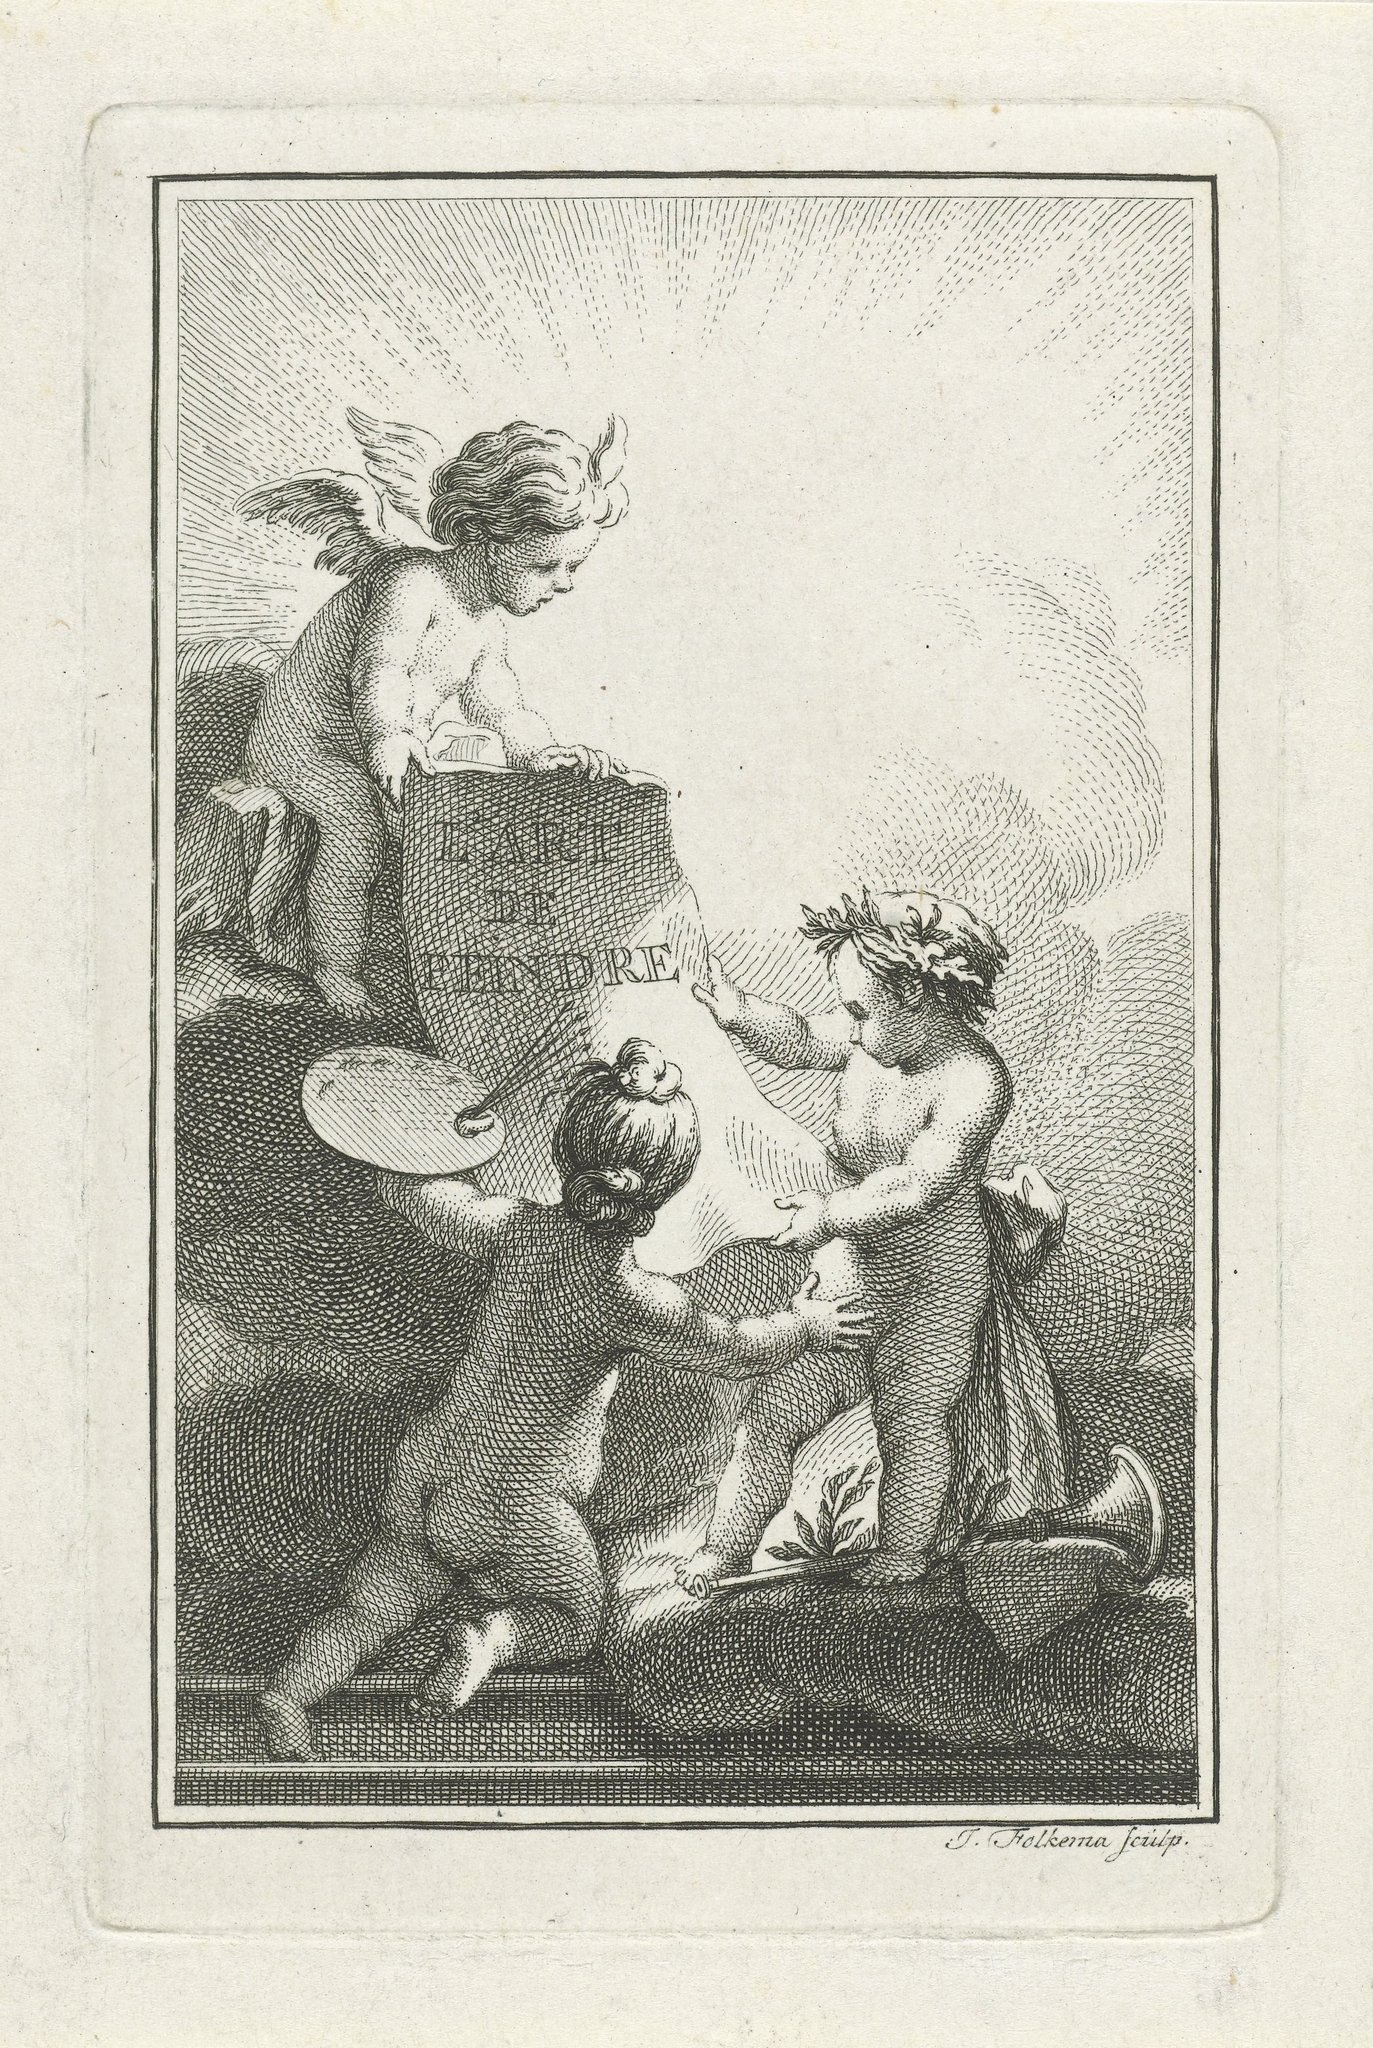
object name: print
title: Putti bestuderen een vel papier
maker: jacob folkema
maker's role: draughtsman, print maker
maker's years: 1692-1767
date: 1761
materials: paper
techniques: etching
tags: cupids together with attributes of the arts, sciences, etc., angel(s) represented as child(ren)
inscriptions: collector's mark: Lugt 240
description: Twee putti bestuderen een vel papier met de tekst: L'Art de Peindre. De linker putto houdt een schilderspalet vast, de rechter is gelauwerd en staat op een bazuin die op de grond ligt. Op een wolk hierboven kijkt een engeltje met een vlam boven het het hoofd, symbool van goddelijke inspiratie, mee.